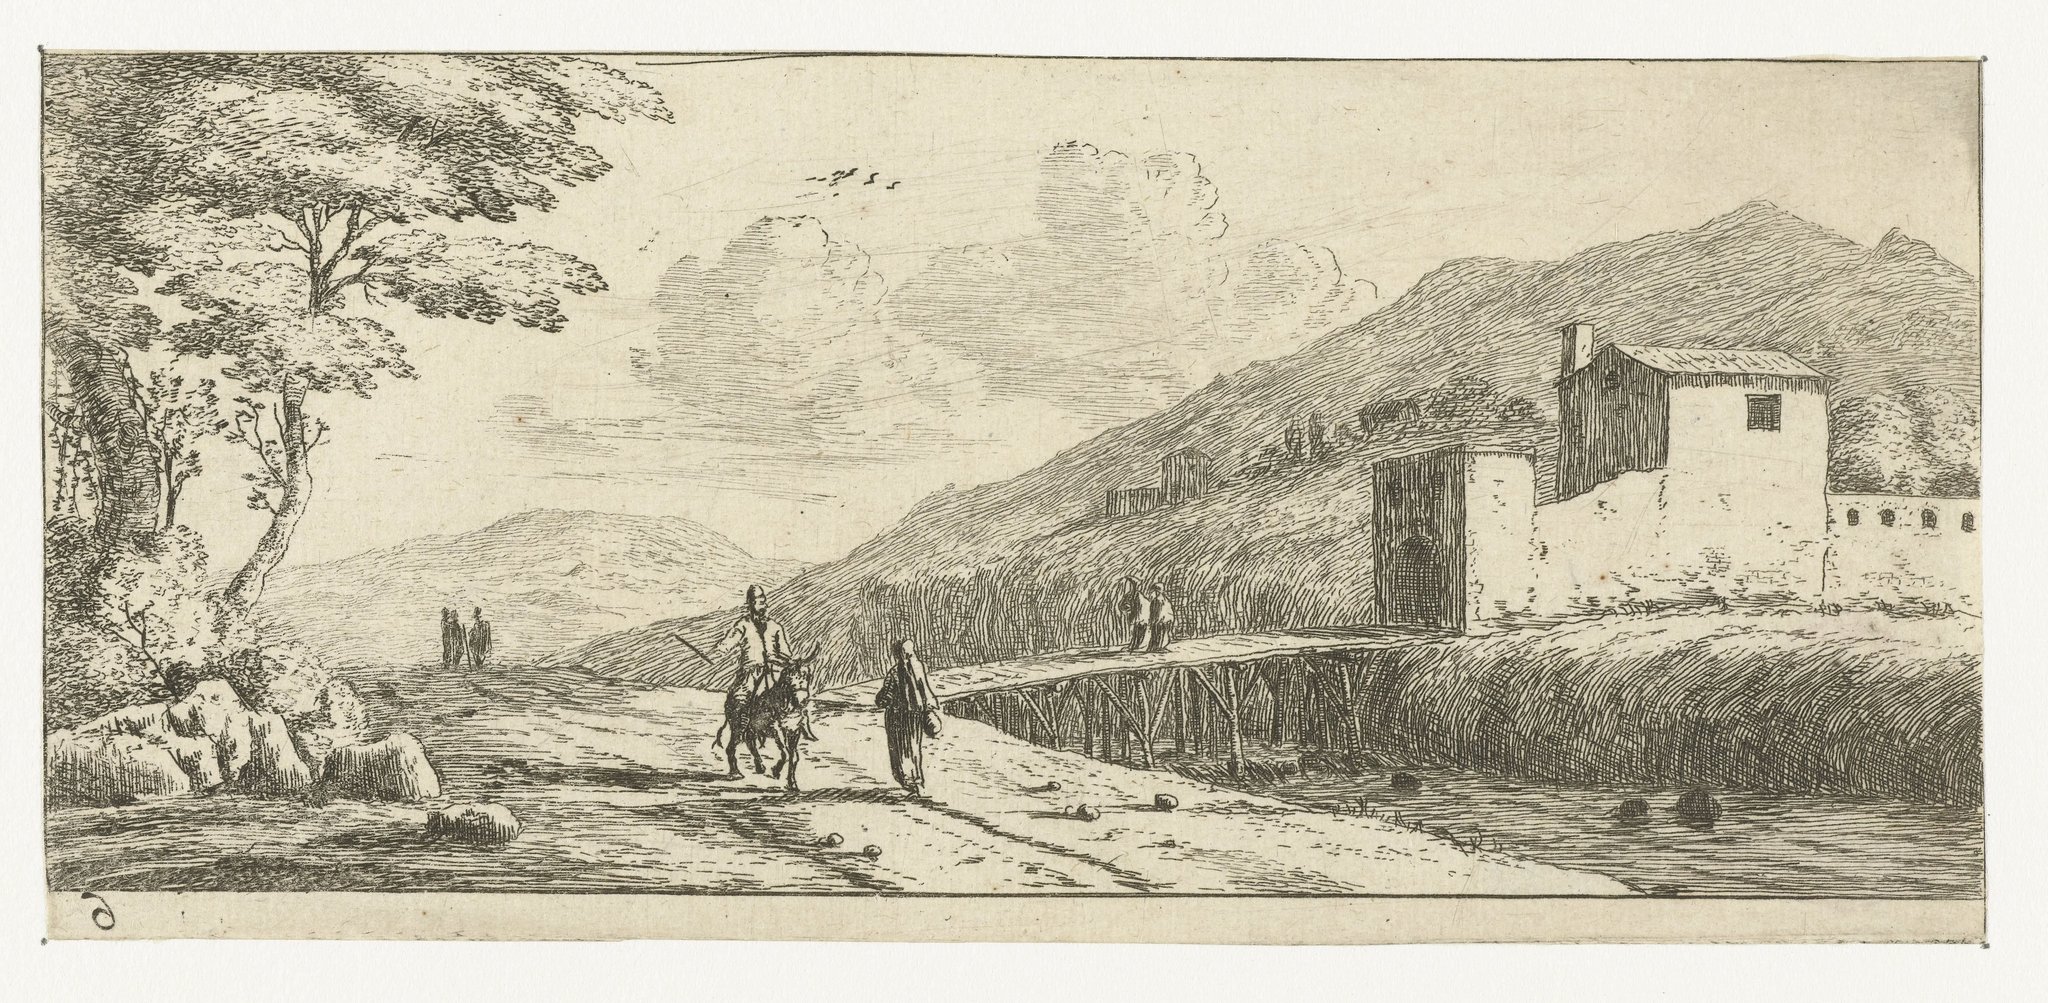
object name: print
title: Landschap met een man op een ezel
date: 1651-1652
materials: paper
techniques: etching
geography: netherlands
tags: ass, donkey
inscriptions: collector's mark: Lugt 12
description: Heuvelig landschap met een man rijdend op een ezel lang een rivier. Een brug bij gebouw op de oever.